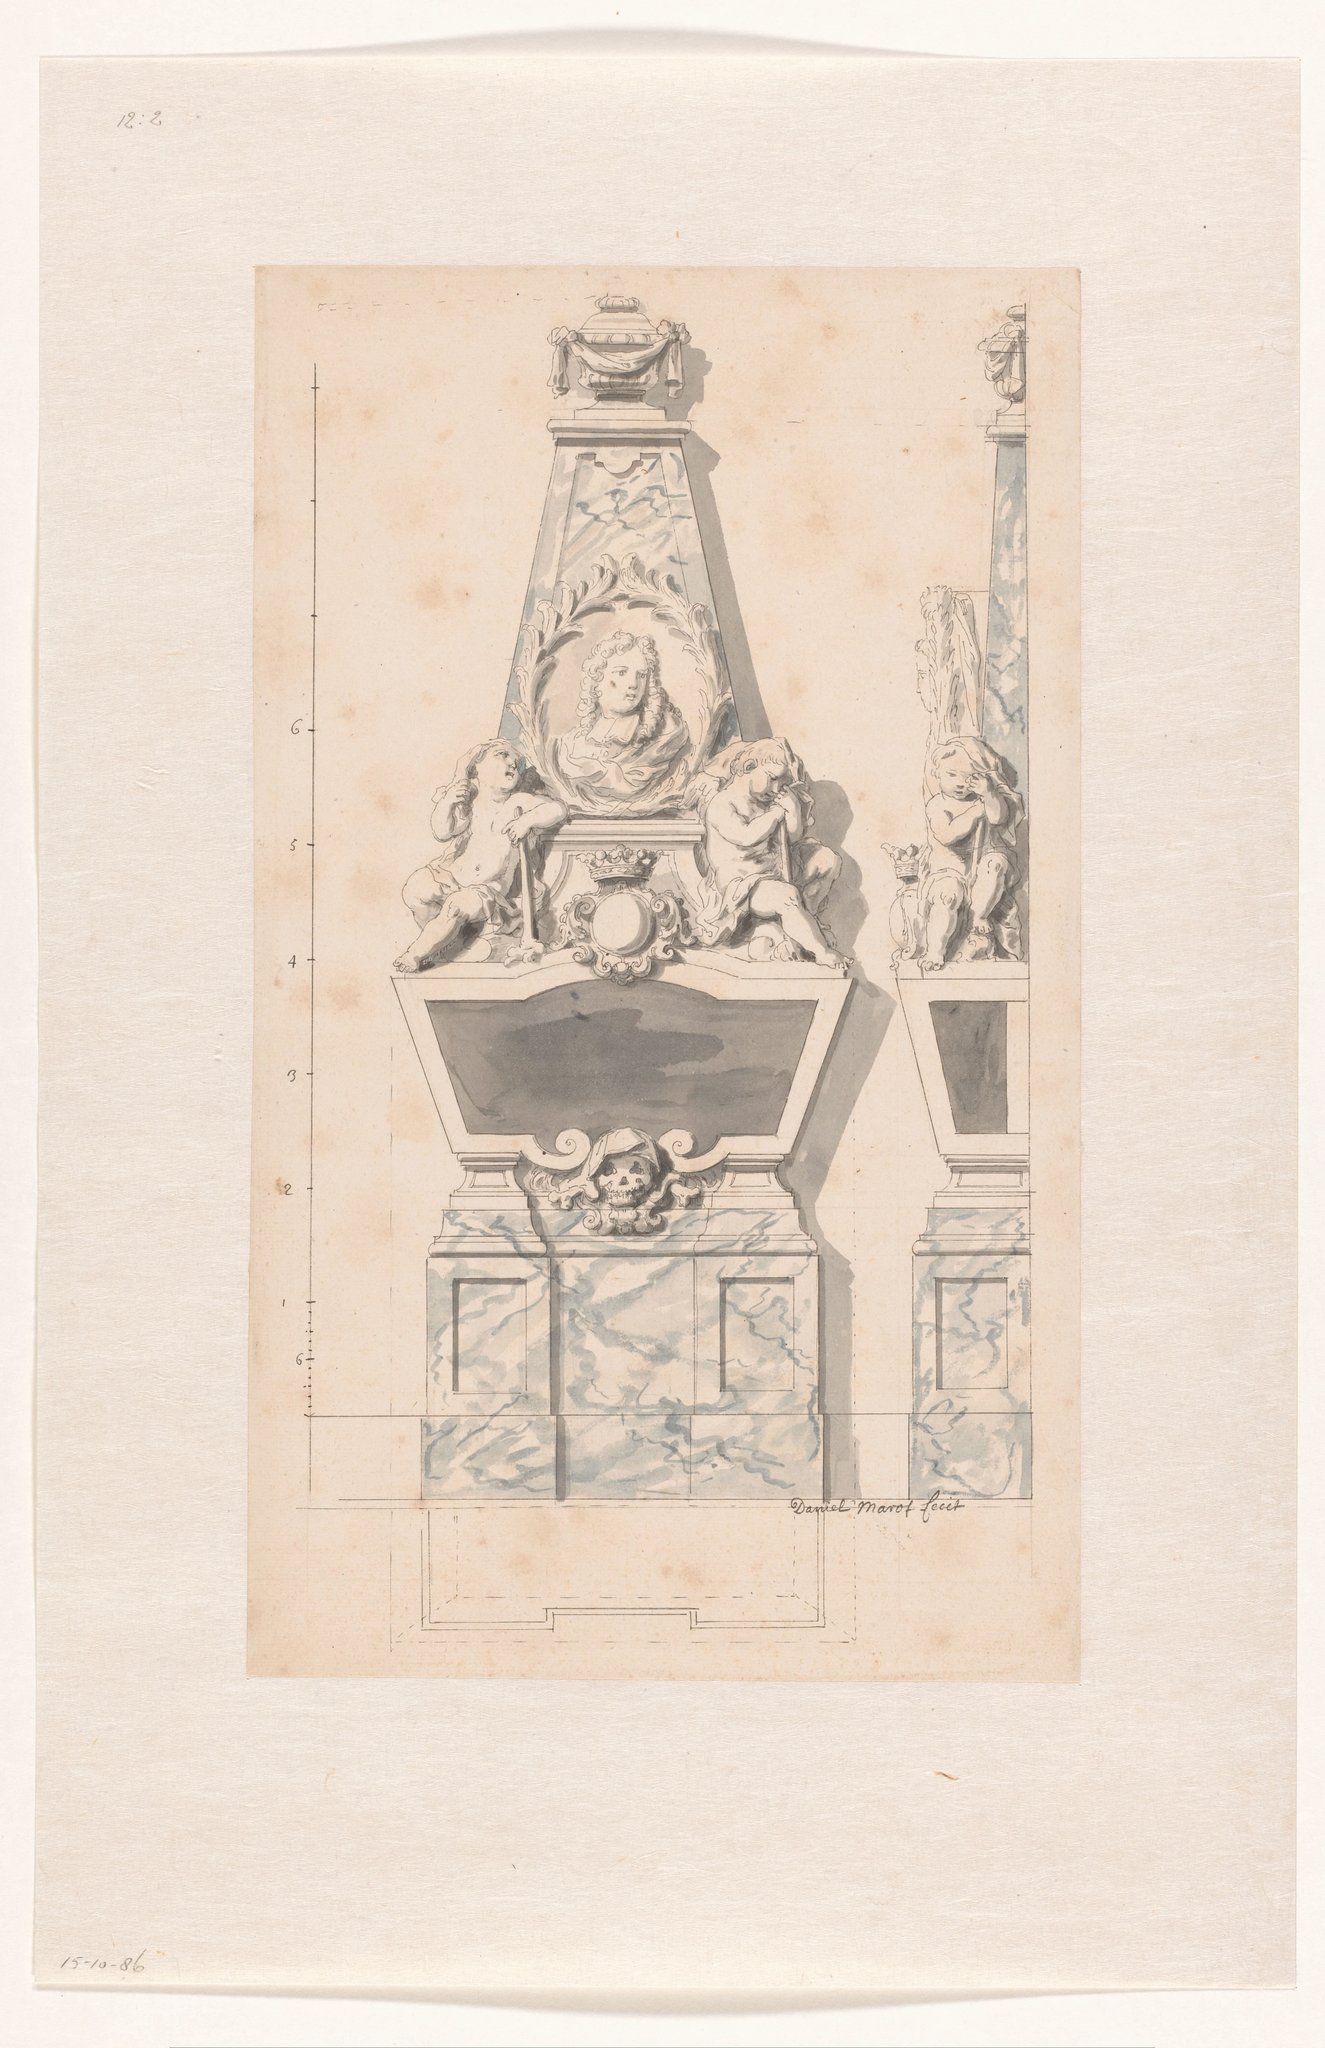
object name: design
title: Front-aanzicht met plattegrond en zij-aanzicht van grafmonument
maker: daniël marot (i)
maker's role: draughtsman, print maker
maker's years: 1661-1752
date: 1672-1752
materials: ink, paper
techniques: brush, pen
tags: grave-building, monumental tomb